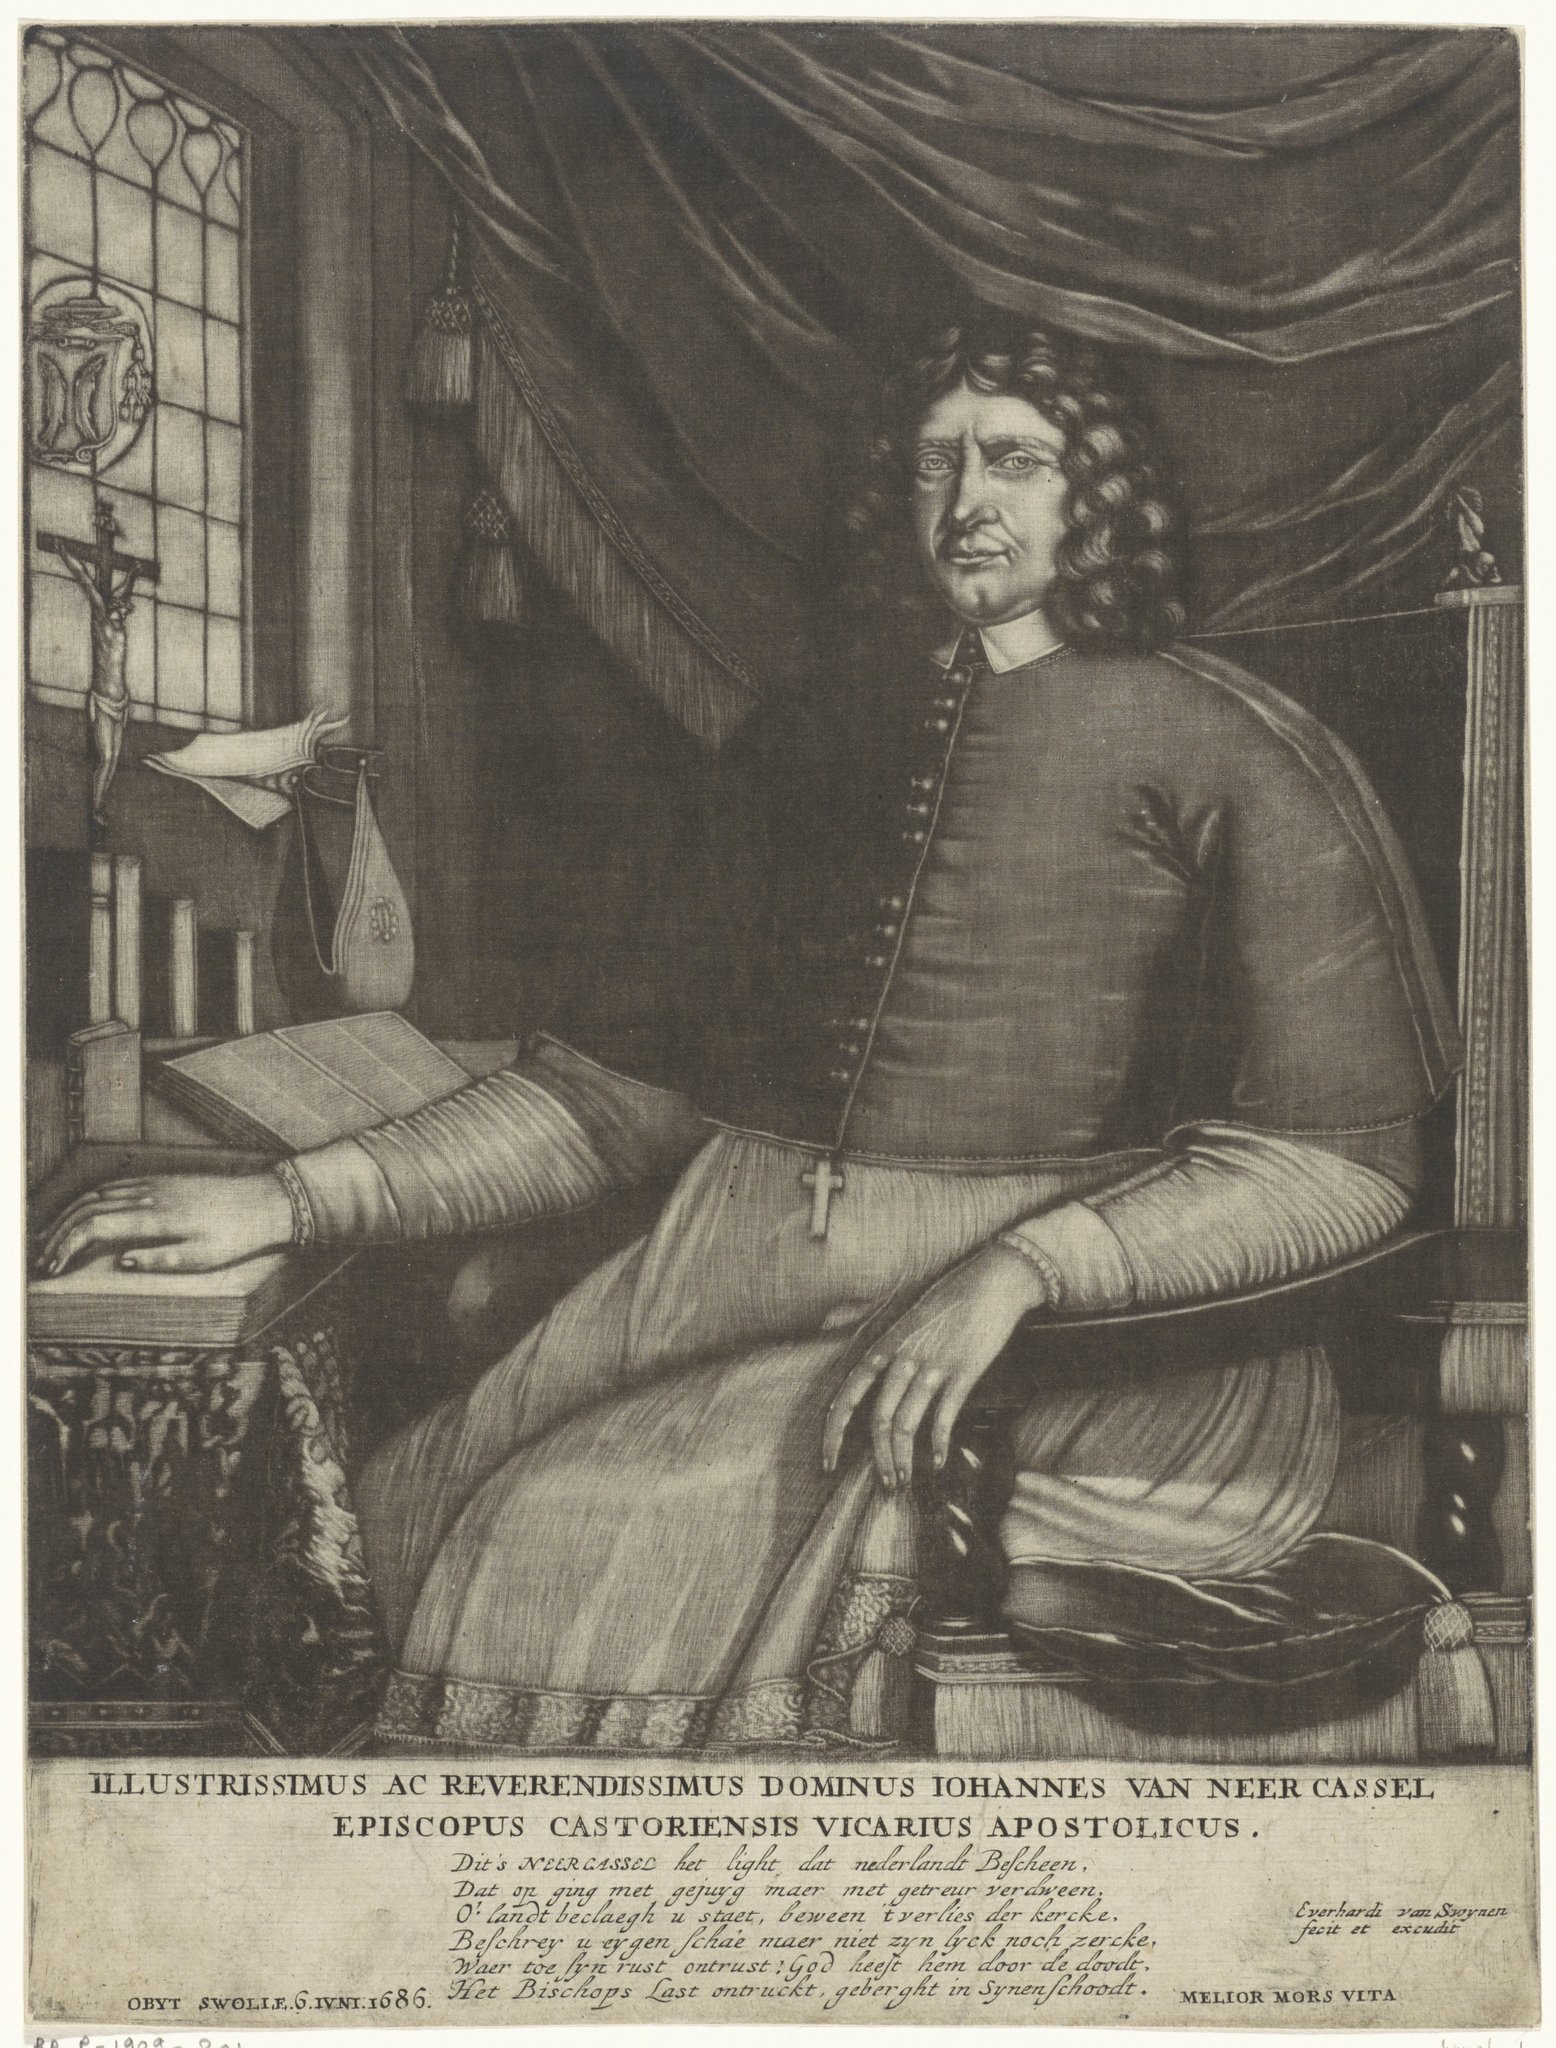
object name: print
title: Portret van Johannes van Neercassel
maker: evert van sweinen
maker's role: print maker, publisher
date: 1686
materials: paper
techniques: engraving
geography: amsterdam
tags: priest, crucifix ~ personal devotion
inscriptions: collector's mark: Lugt 2228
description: Johannes van Neercassel, apostolisch vicaris van de Hollandse Missie. Hij zit in een stoel en laat zijn hand op een boek rusten. Op de tafel naast hem een crucifix. In de marge zijn naam, titels en een gedicht ter gelegenheid van zijn overlijden.